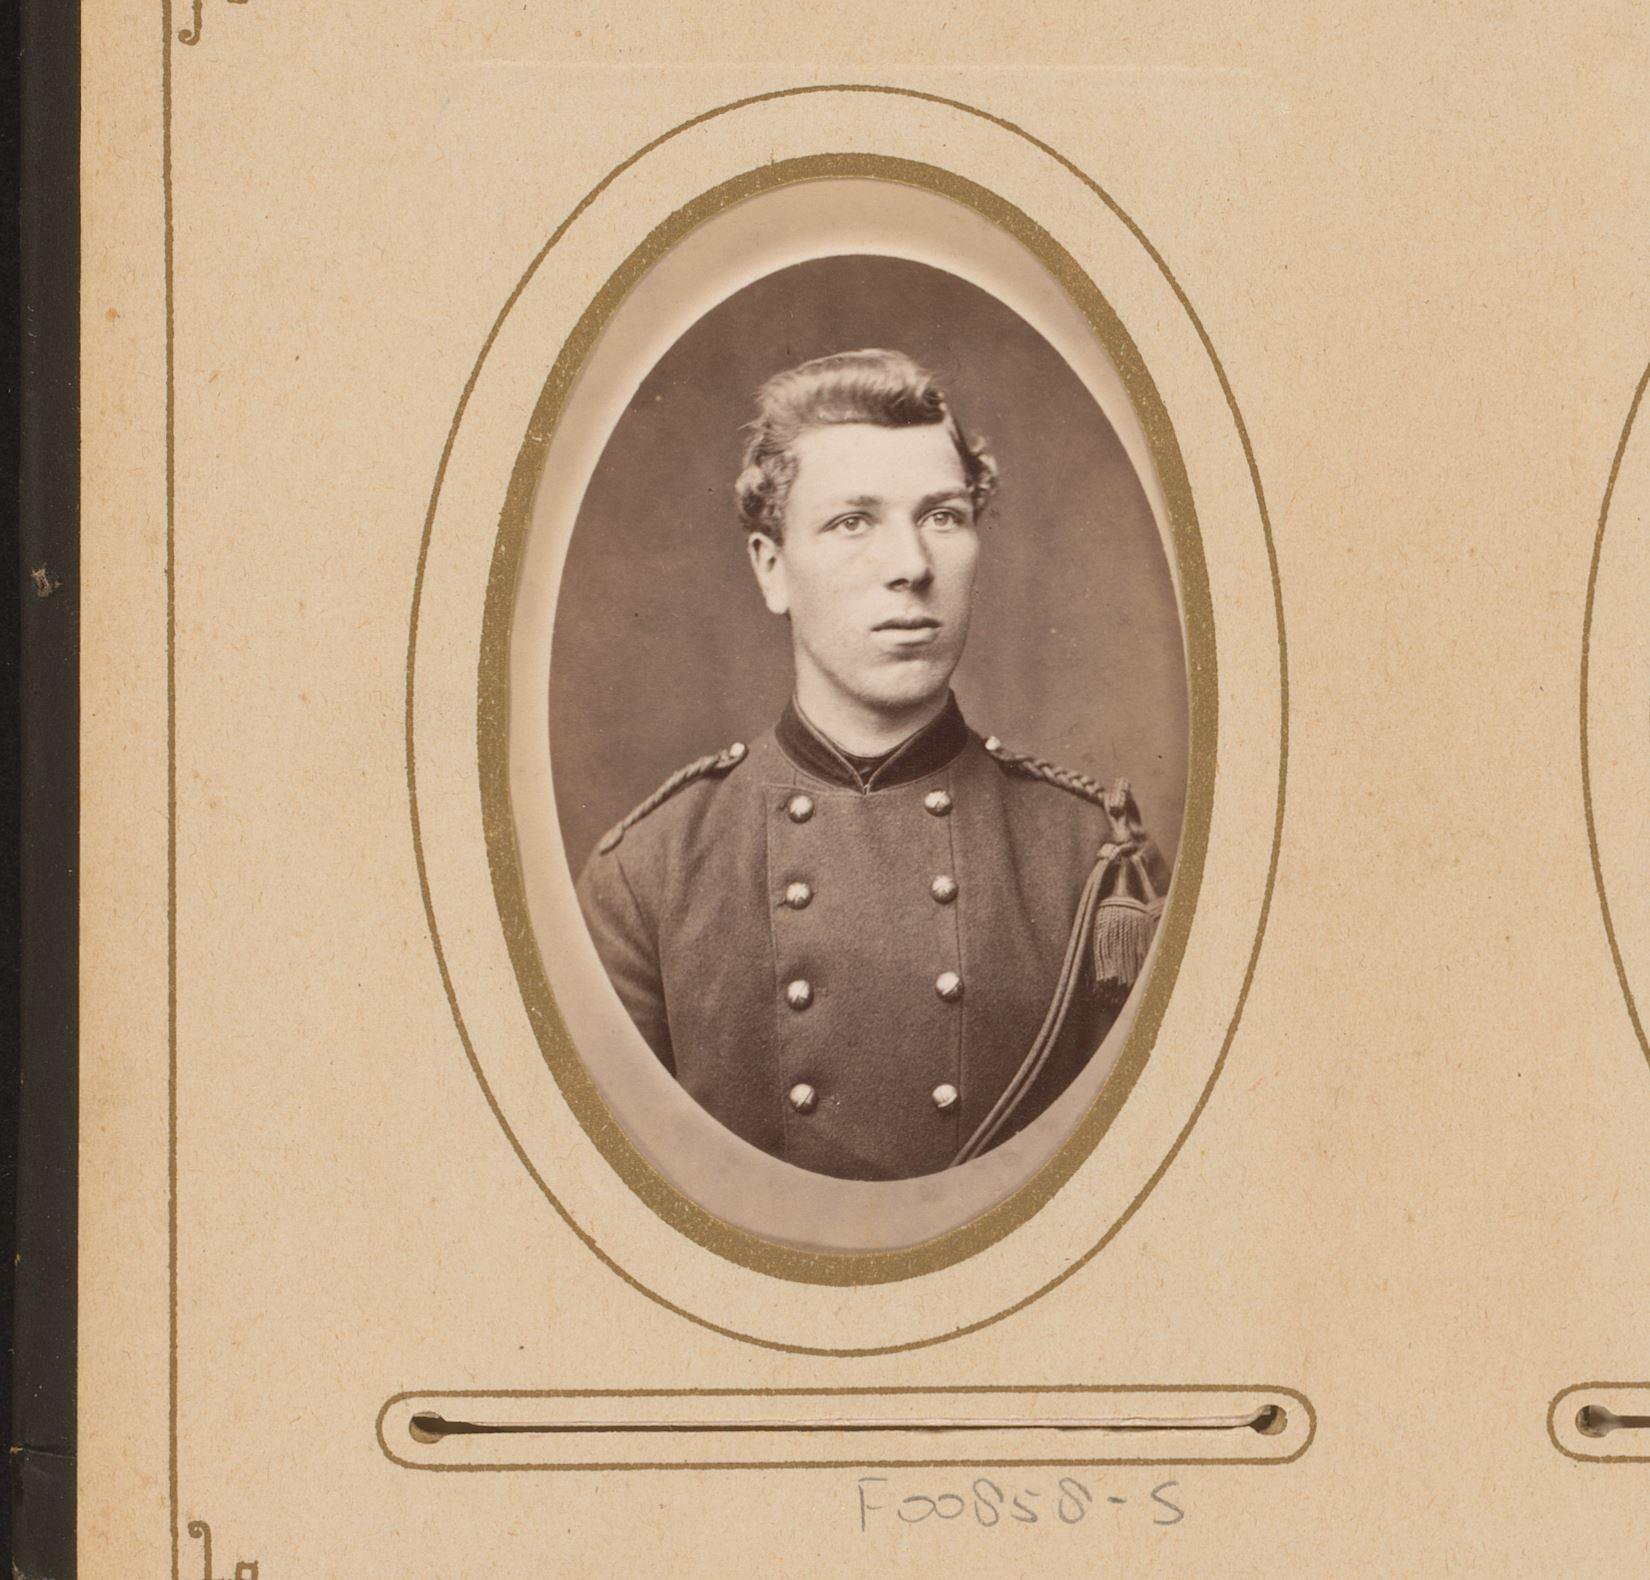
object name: album leaf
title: Portret van een jongeman in militair uniform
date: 1881-1900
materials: cardboard, photographic support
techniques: albumen print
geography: north holland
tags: historical persons, youth, adolescent, (military) uniforms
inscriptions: inscription: ‘Alkmaar, Verdronken Oord; Nieuwediep, Kanaalweg tegenover Tivoli; Schagen’